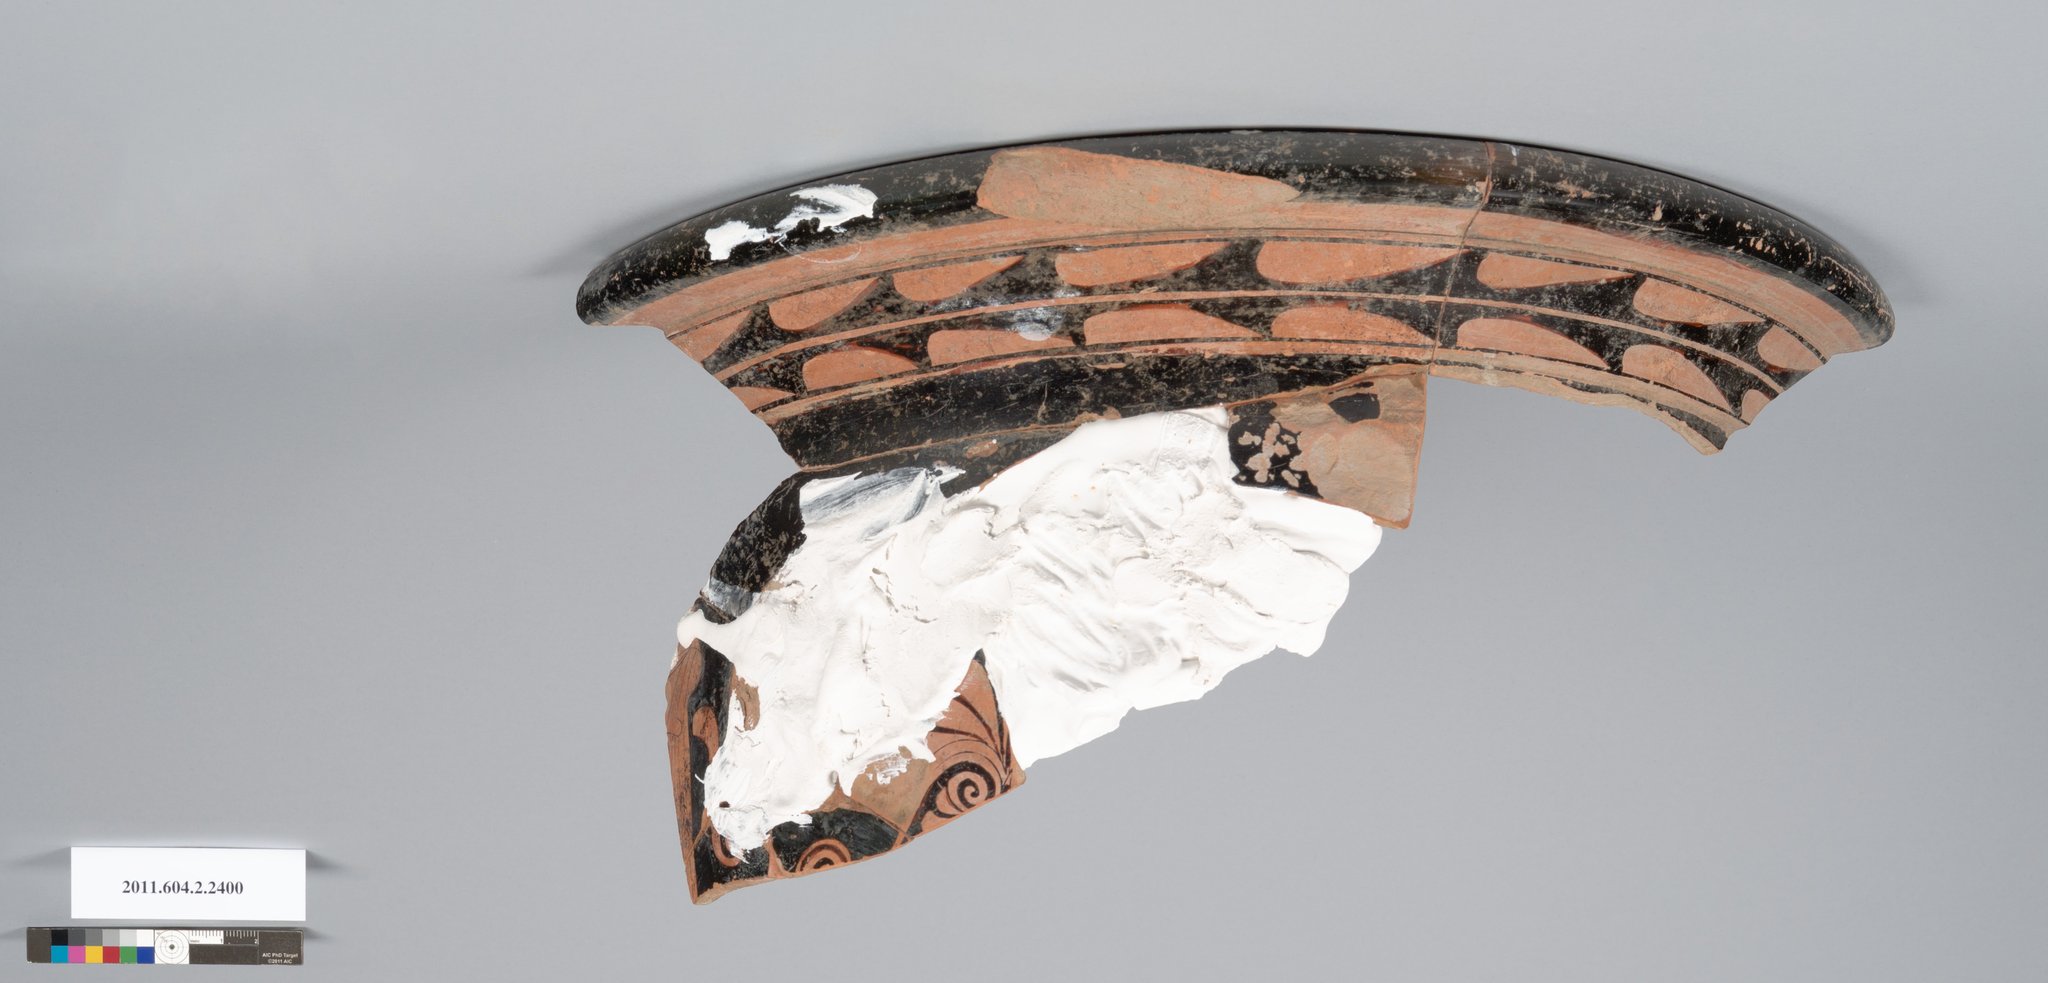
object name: bell krater fragment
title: Terracotta fragment of a bell-krater (bowl for mixing wine and water)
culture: greek, attic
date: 460-440 BCE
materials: terracotta